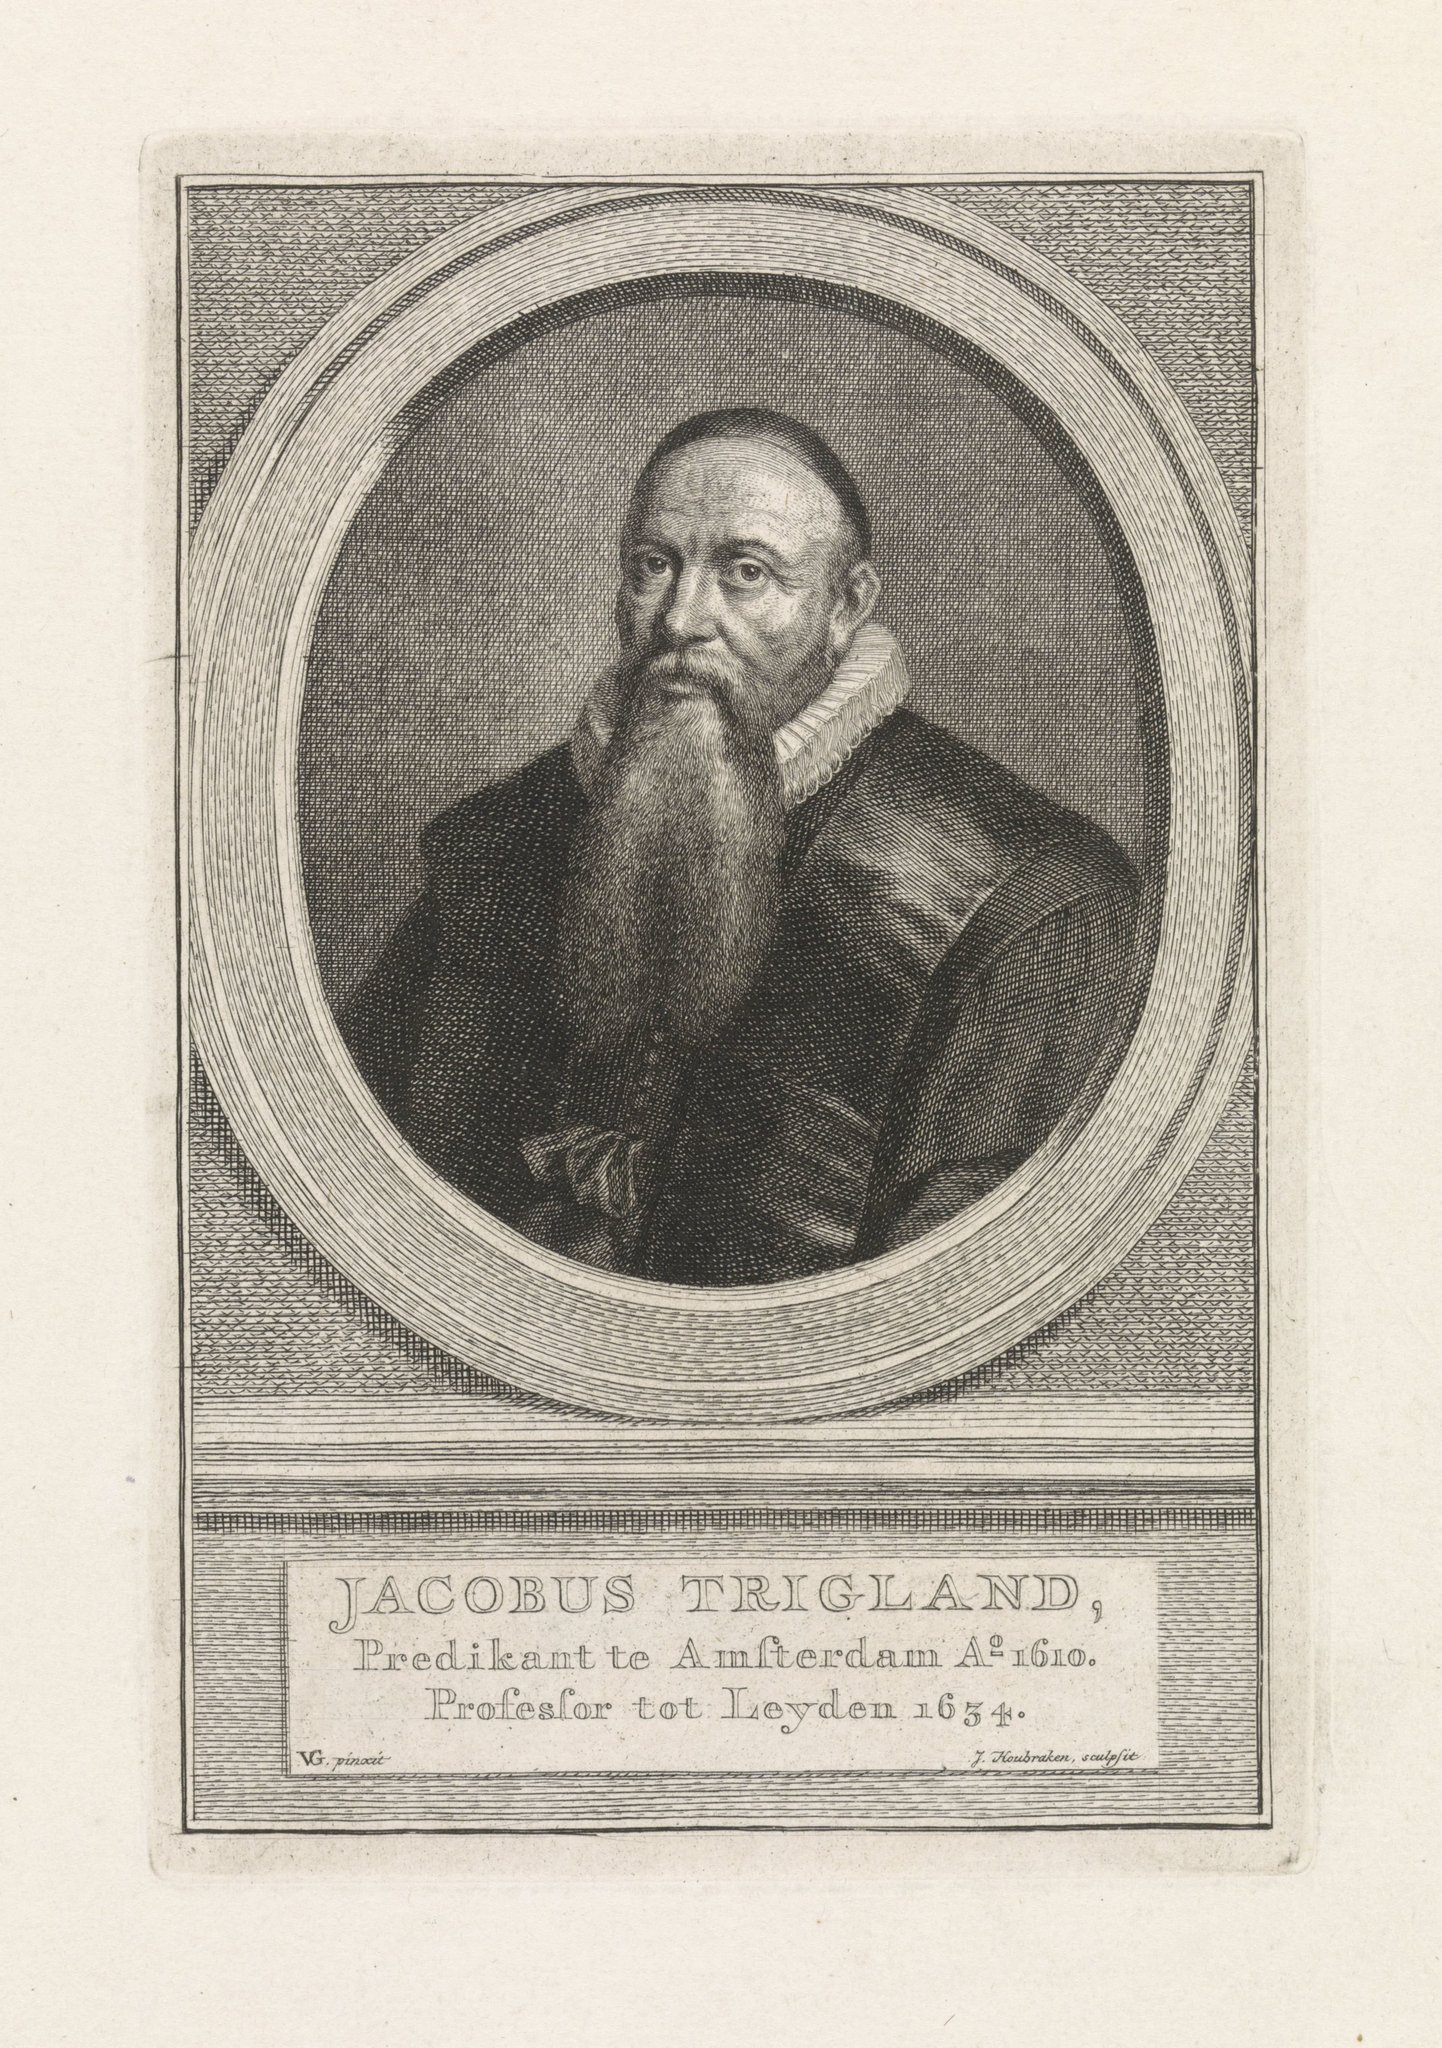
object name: print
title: Portret van Jacobus Trigland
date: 1749-1759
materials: paper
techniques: engraving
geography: amsterdam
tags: jacobus trigland (i)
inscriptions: collector's mark: Lugt 2228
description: Prent oorspronkelijk bedoeld voor: Jan Wagenaar, Vaderlandsche historie, vervattende de geschiedenissen der nu Vereenigde Nederlanden, inzonderheid die van Holland (...), 21 delen. Amsterdam, Isaak Tirion, 1749-59.